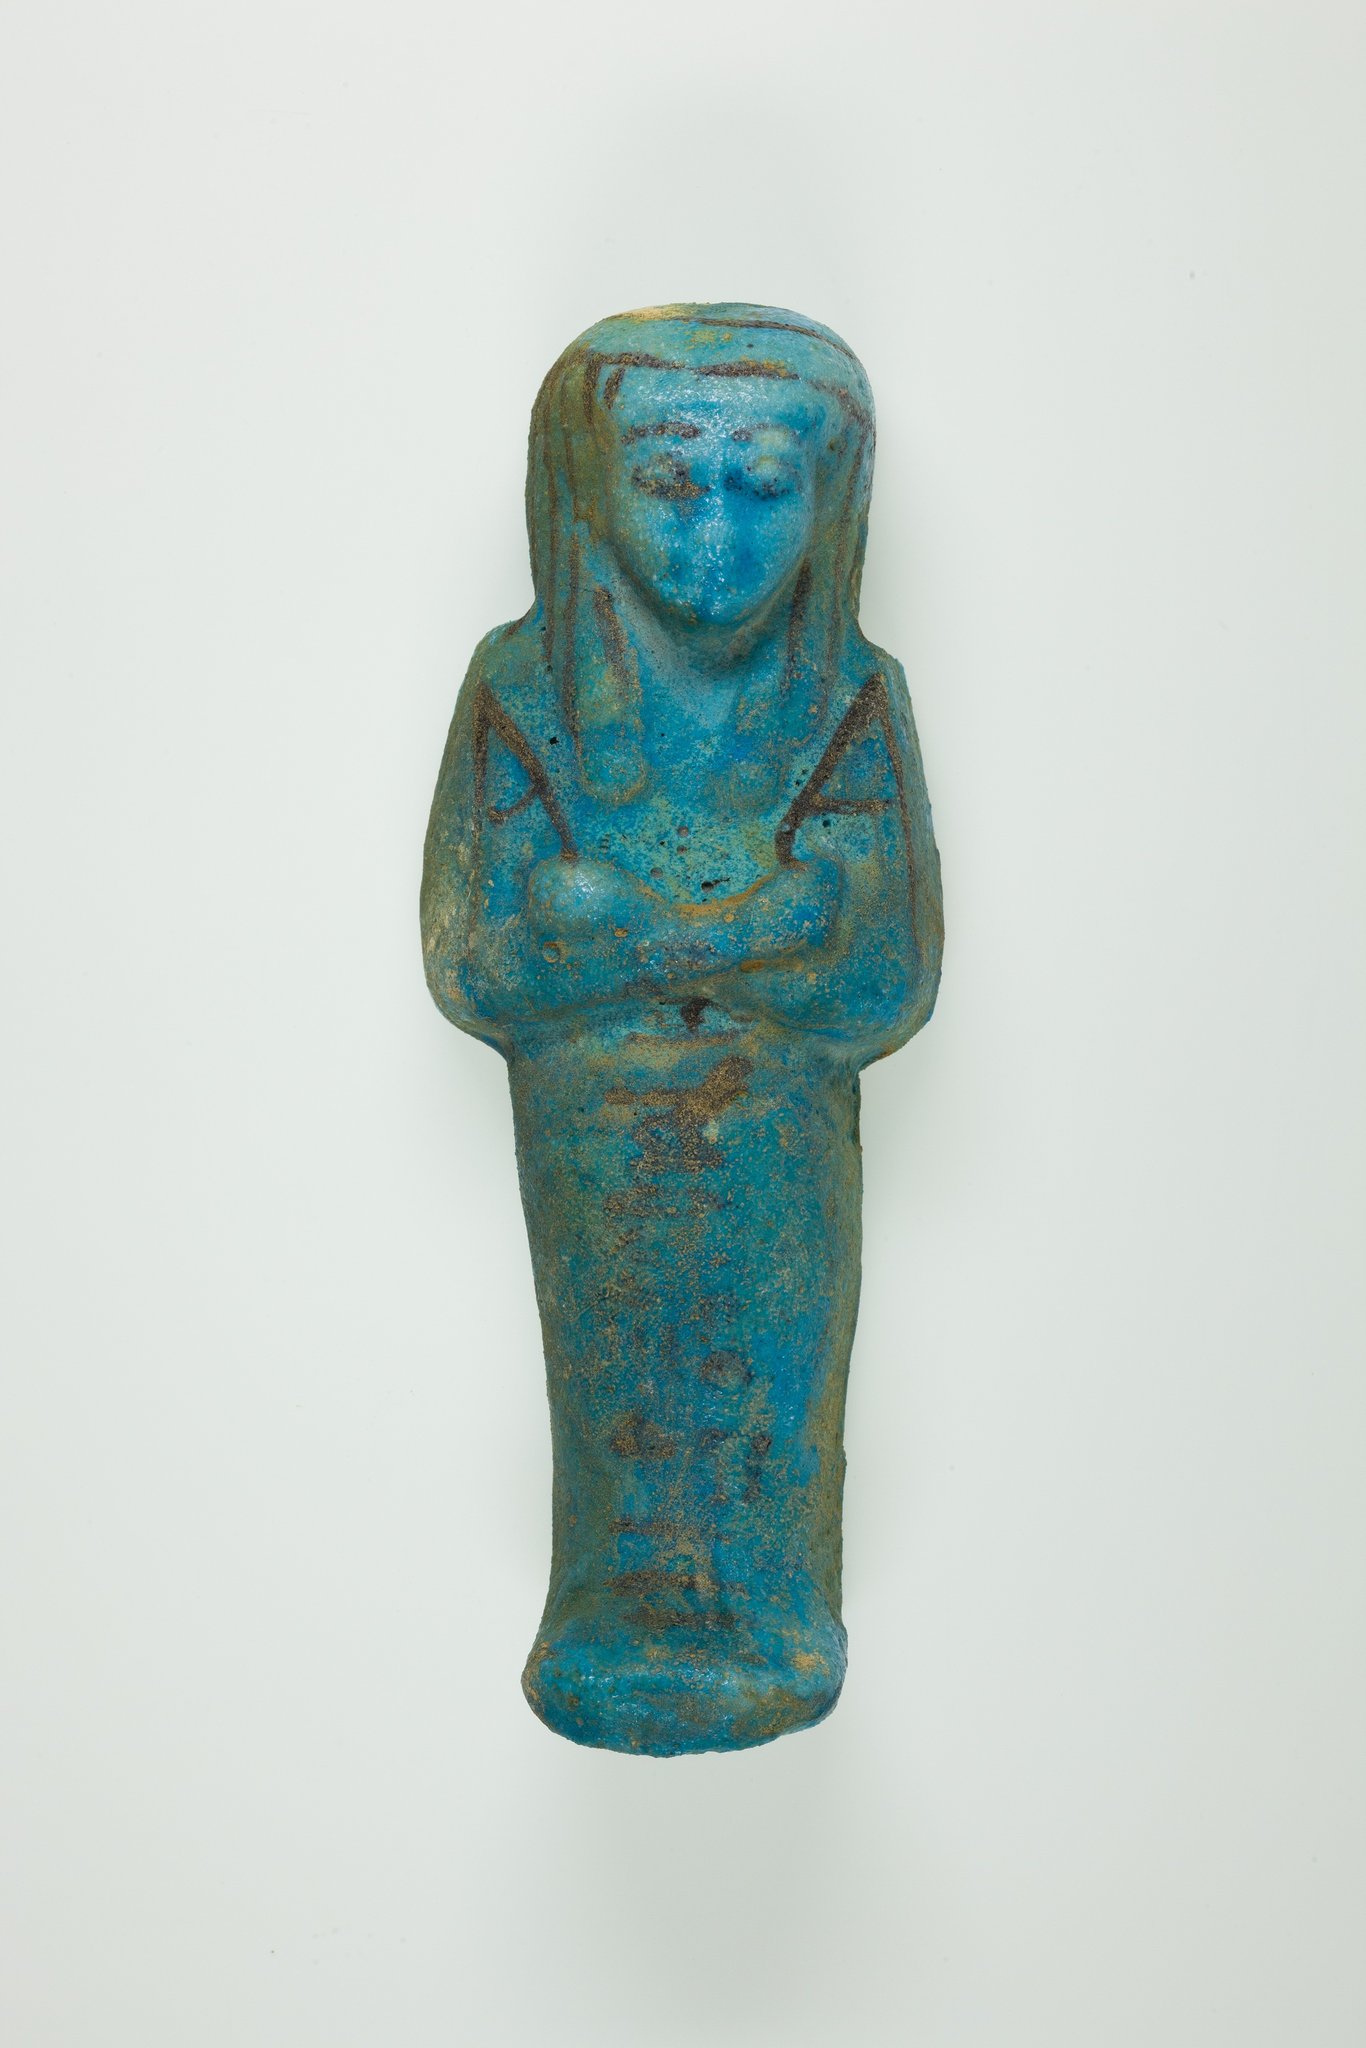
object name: worker shabti, henettawy c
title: Worker Shabti of Henettawy (C), Daughter of Isetemkheb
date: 990-970 BCE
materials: faience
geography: egypt